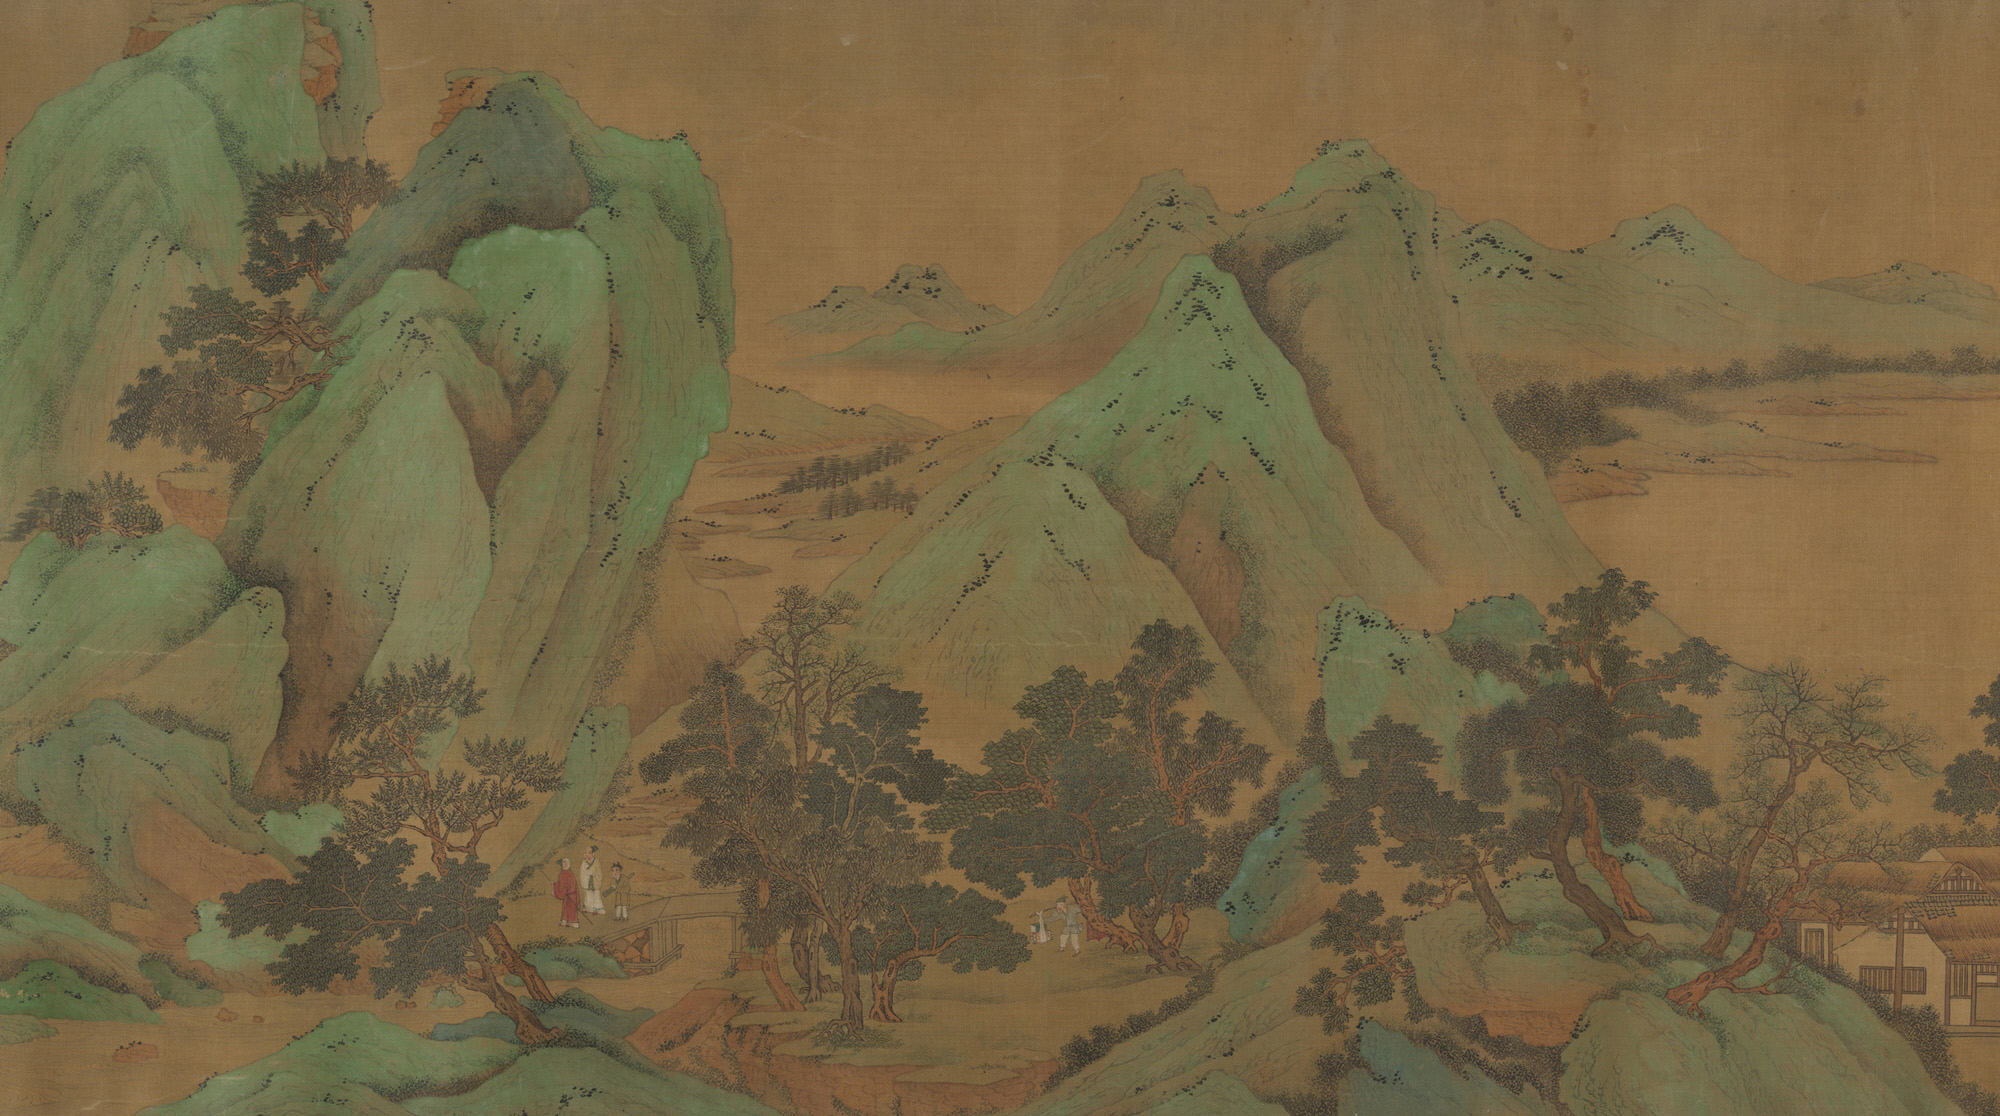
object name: handscroll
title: Garden estate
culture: chinese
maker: unidentified artist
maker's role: artist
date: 1601-1700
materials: ink, silk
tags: mountains,landscapes,trees